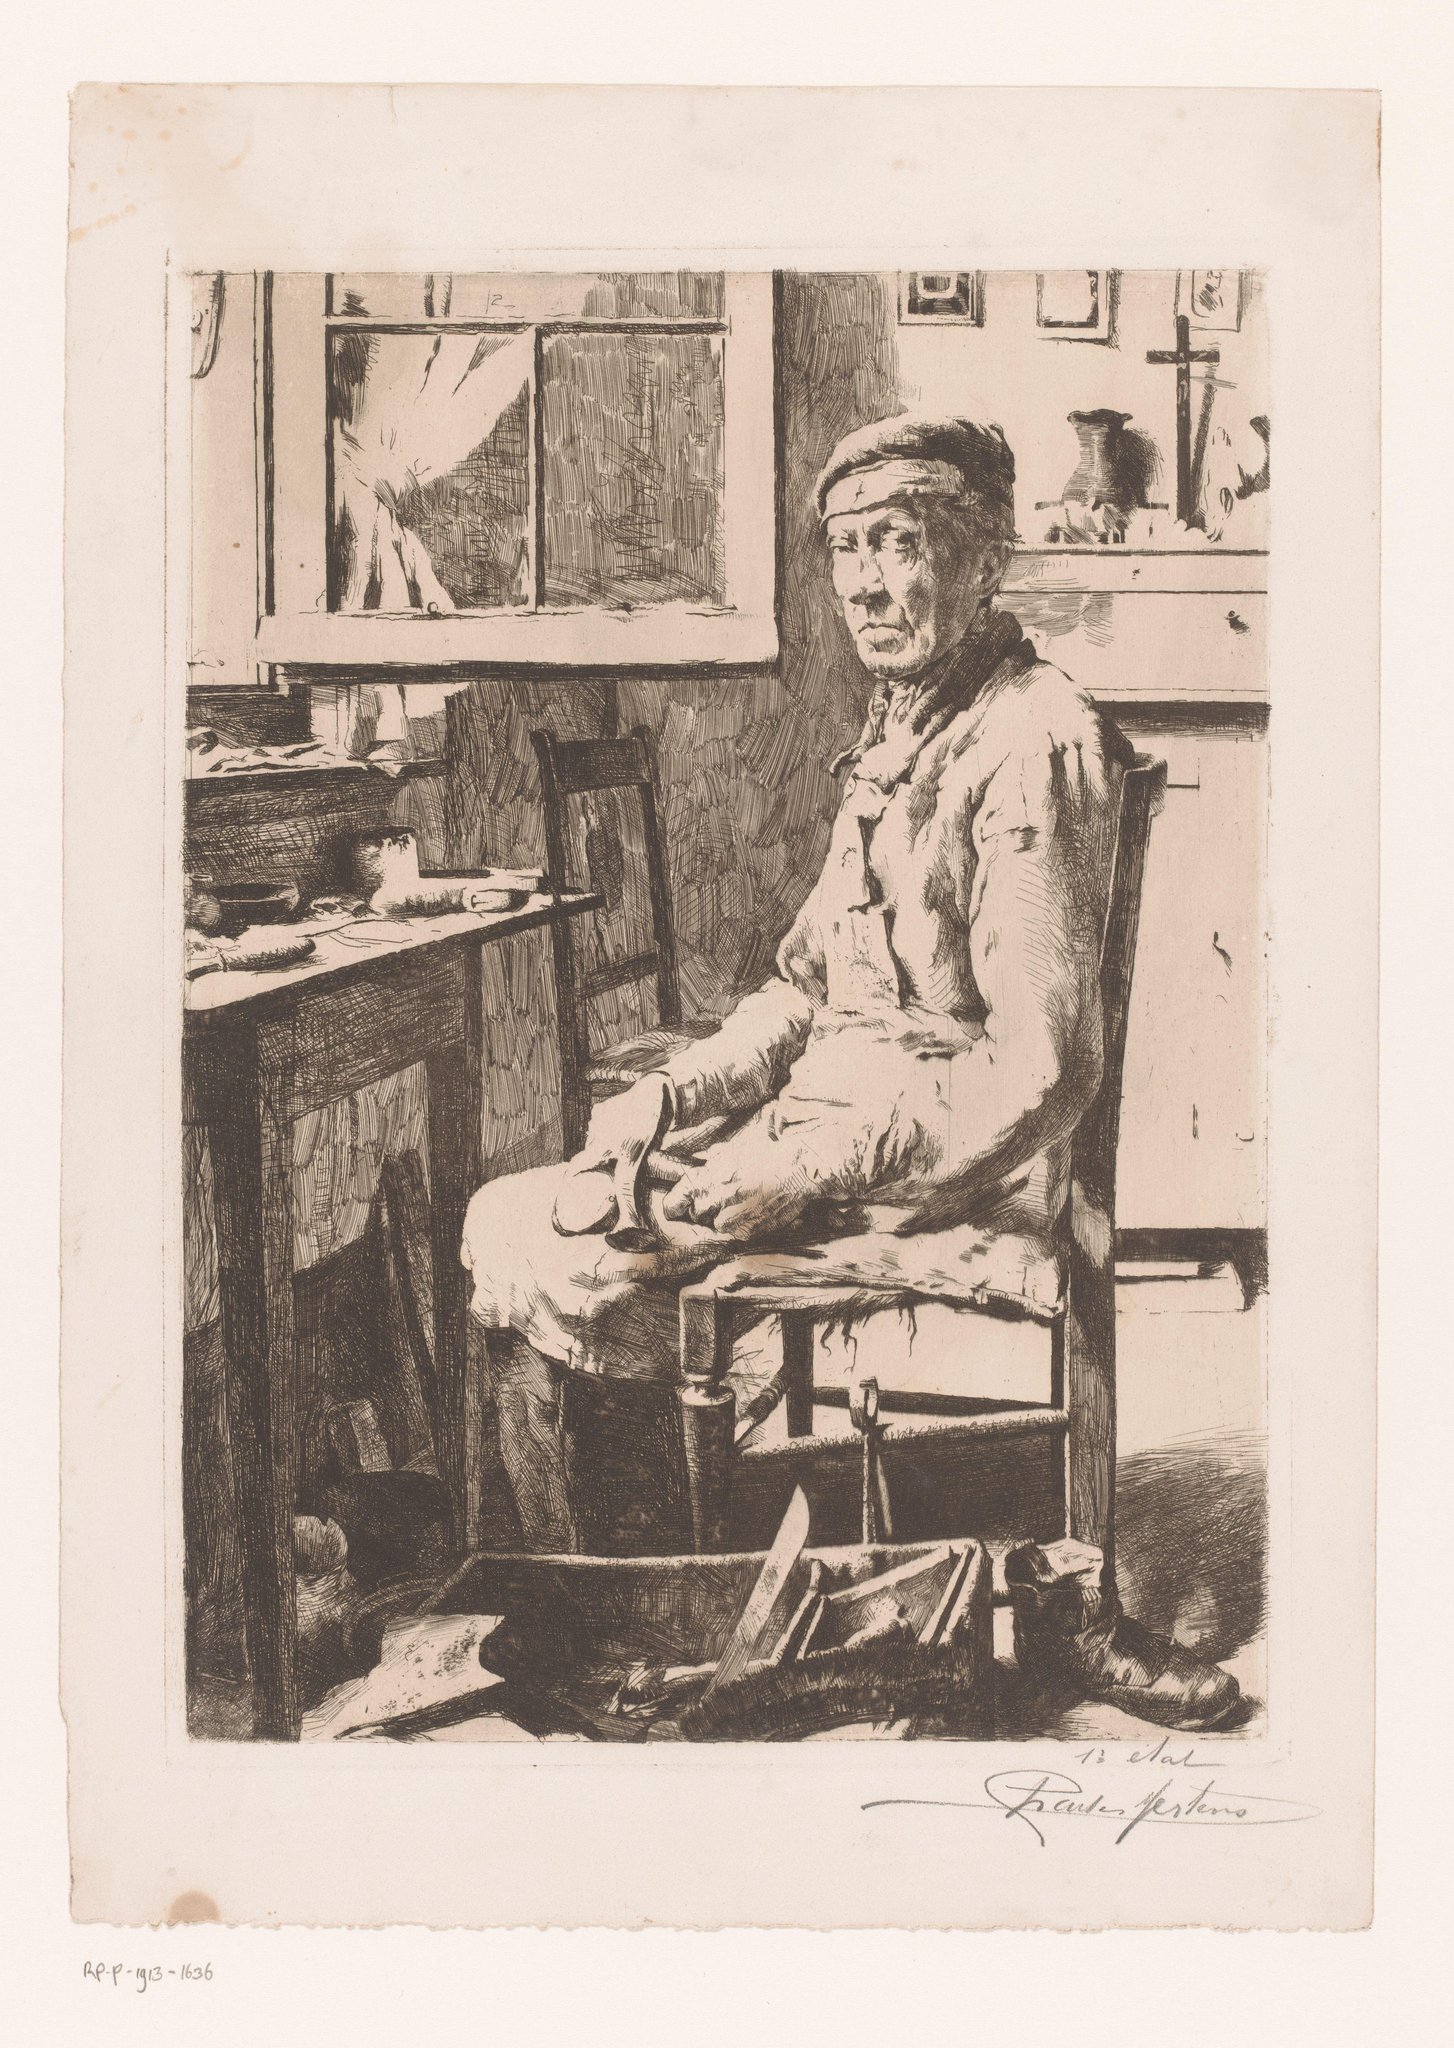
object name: print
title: Schoenmaker aan het werk in een werkplaats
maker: charles mertens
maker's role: print maker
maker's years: 1865-1919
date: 1886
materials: paper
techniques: etching, intaglio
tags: old man, workshop-interior, shoe-maker, cobbler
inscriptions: collector's mark: Lugt 2228, inscription: ‘1e etat’